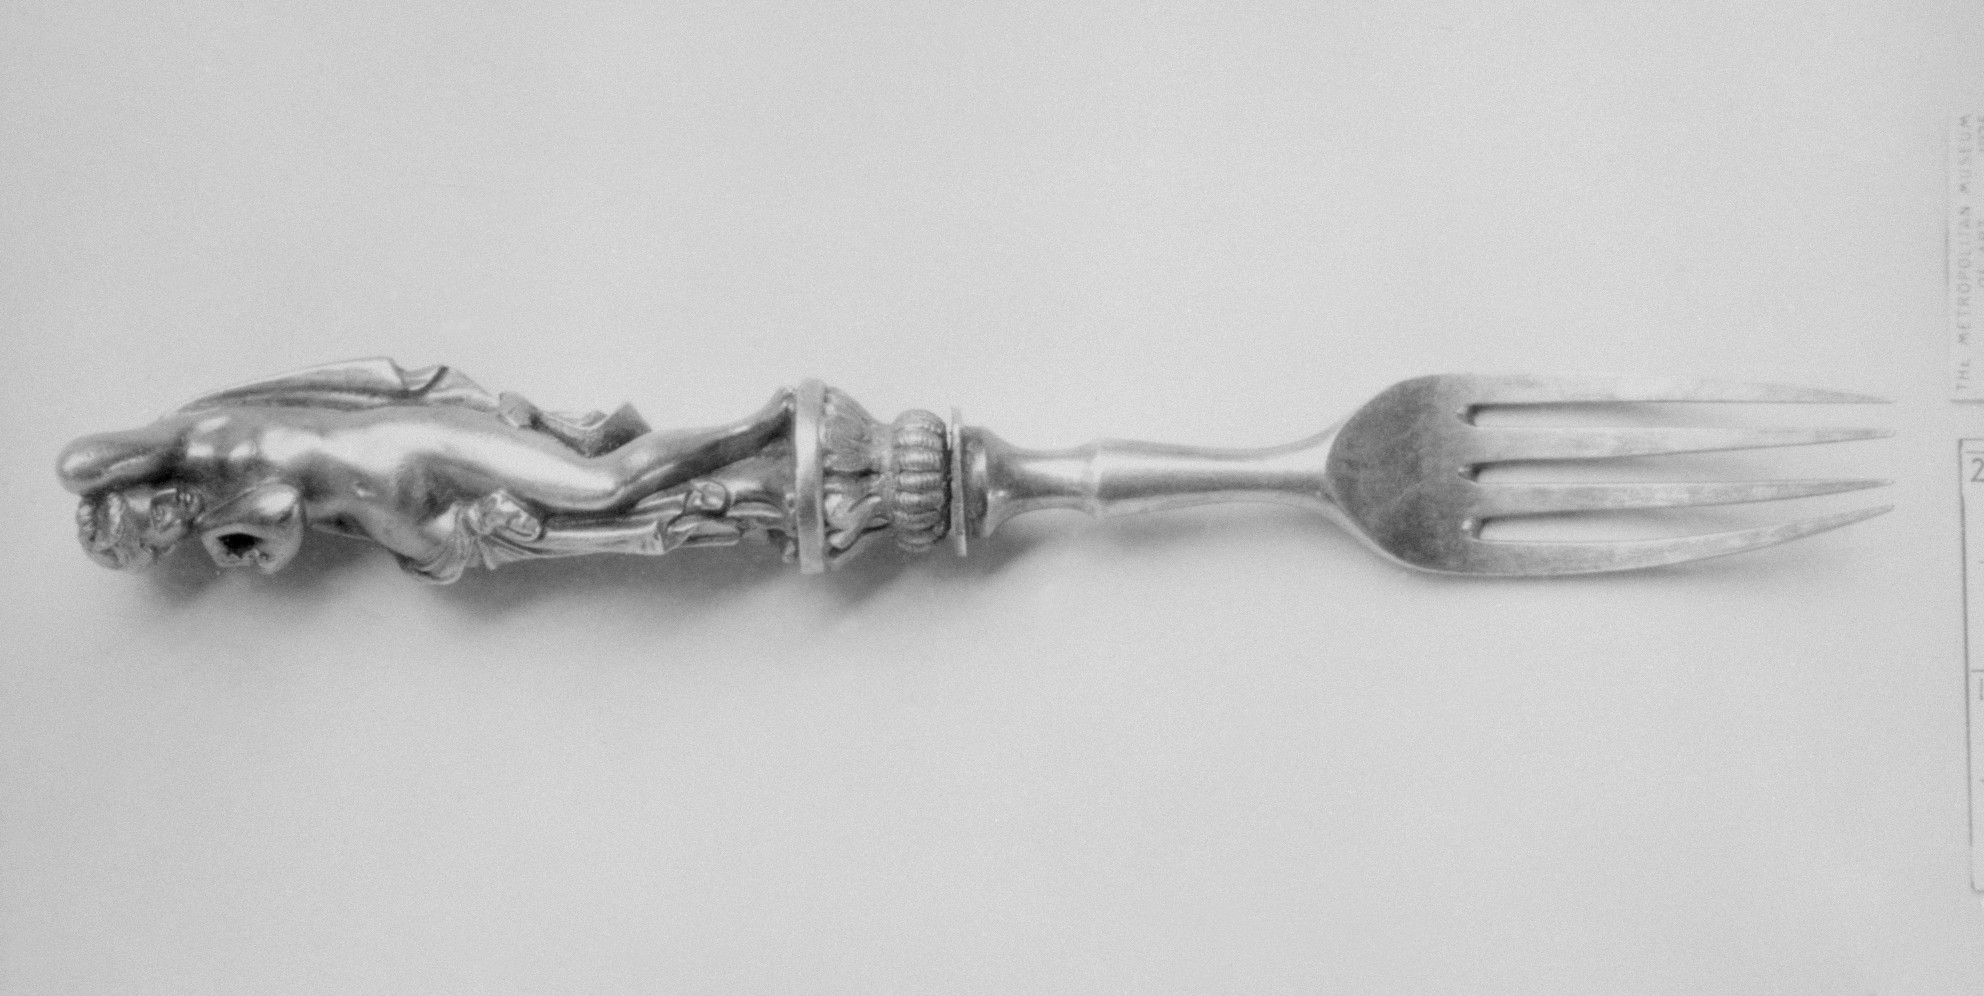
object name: fork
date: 1801-1900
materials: silver gilt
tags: female nudes